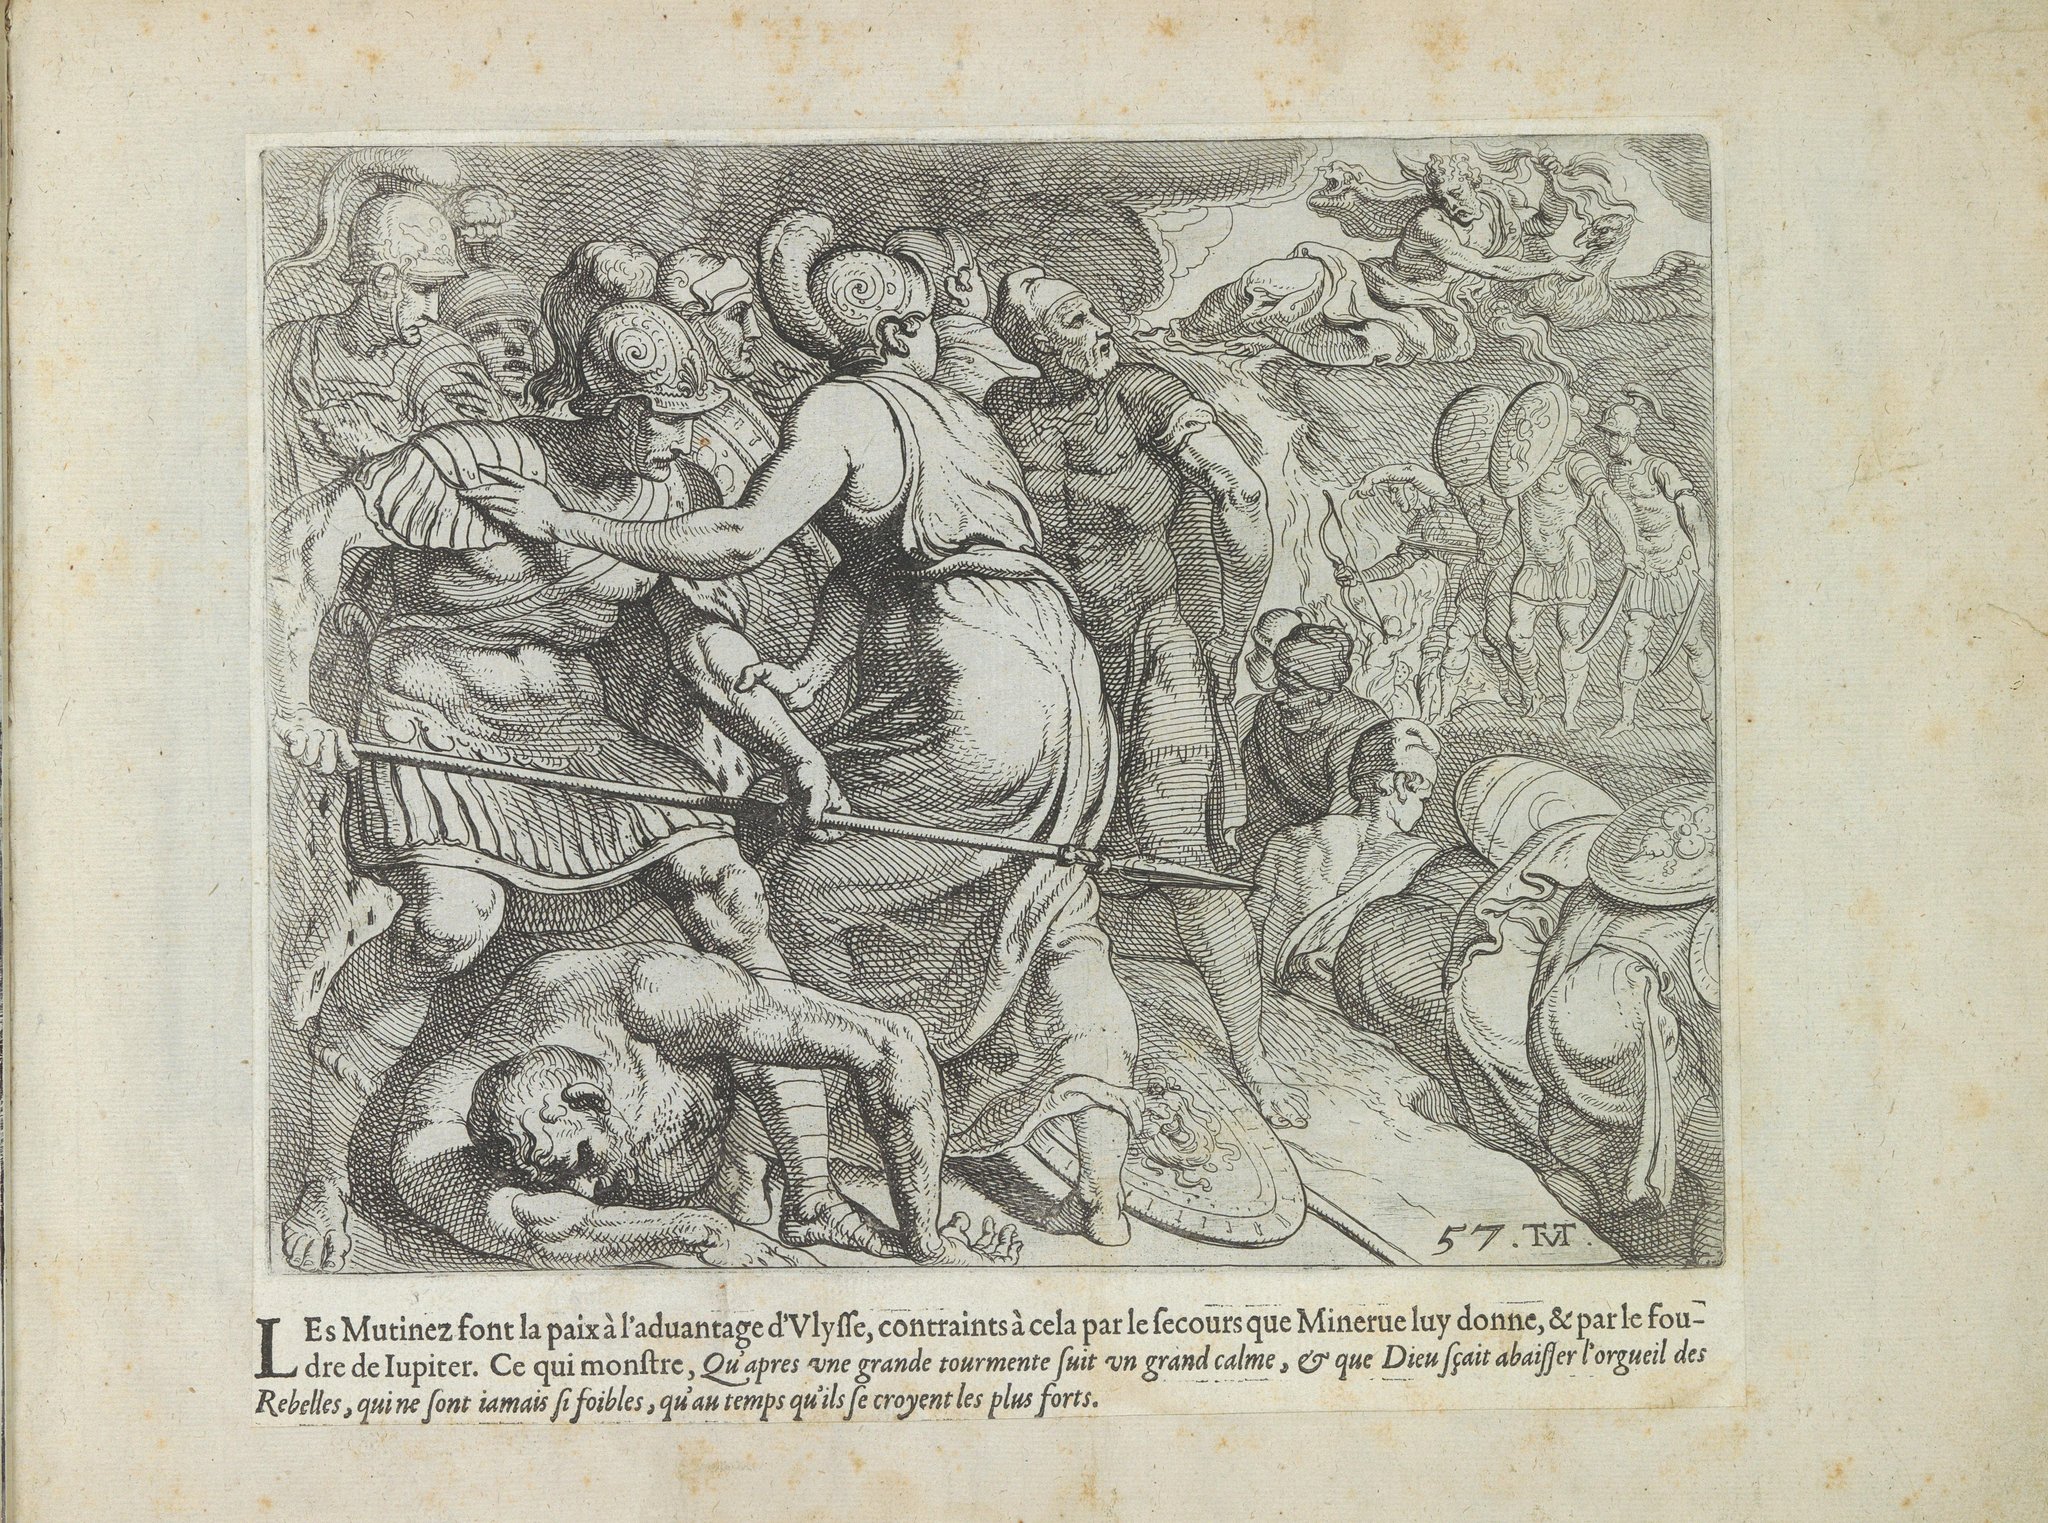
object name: print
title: Les Travaux d'Ulysse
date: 1633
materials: paper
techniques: engraving, etching, letterpress printing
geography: paris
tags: minerva intervenes; reconciliation of ulysses and the ithacan rebels, (story of) jupiter (zeus), attributes of jupiter: thunderbolt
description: Jupiter stopt de strijd tussen Odysseus en de Ithacanen. Odysseus wordt tegengehouden door Minerva. Aan de voeten van hem ligt een dode man. De prent maakt deel uit van een album.